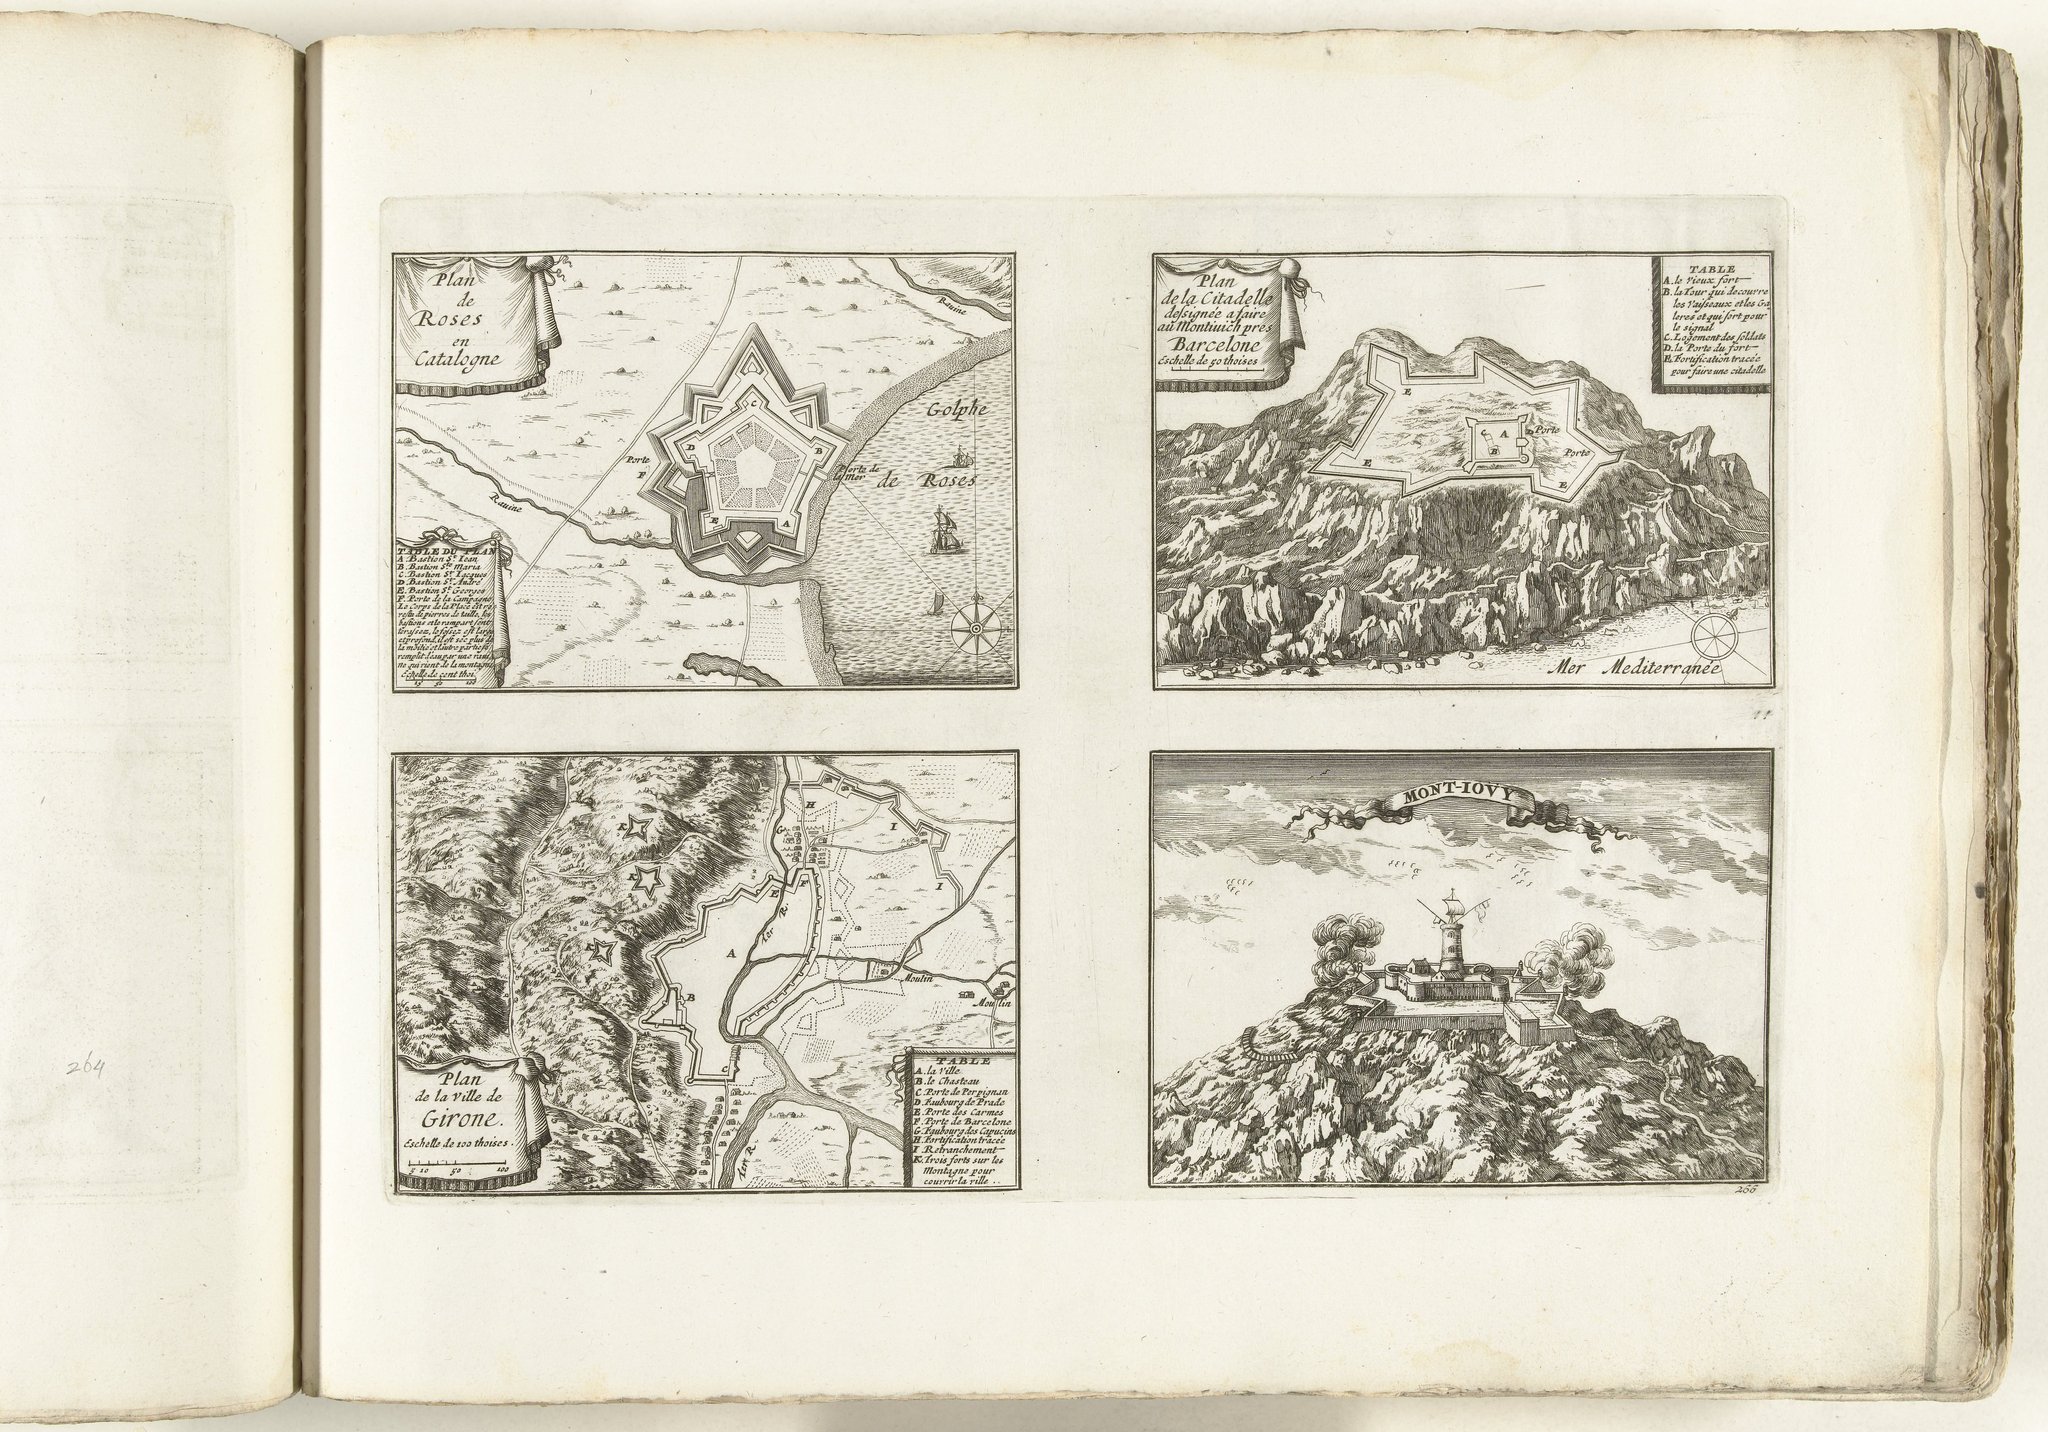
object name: print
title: Roses / Montivich / Girone / Mont-Jouy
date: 1702-1703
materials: paper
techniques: etching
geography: northern netherlands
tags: fortress, maps of cities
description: Blad met vier plattegronden van de versterkingen om Rosas, Gerona en andere plaatsen in Catalonië. Plaat nr. 266 in het prentwerk bestaande in totaal uit 276 genummerde platen van vermaarde sterke steden en vestingen in het kader van de Spaanse Successieoorlog. Voor het merendeel zijn deze platen gekopieerd naar de anonieme Franse platen: in Les forces de l'Europe en in: Le theatre de la guerre, dans les Pays-Bas, beide oorspronkelijk uitgegeven door Nicolas de Fer te Parijs (1693-1697) in het kader van de Negenjarige Oorlog. Titels en opschriften in de plaat in het Frans.